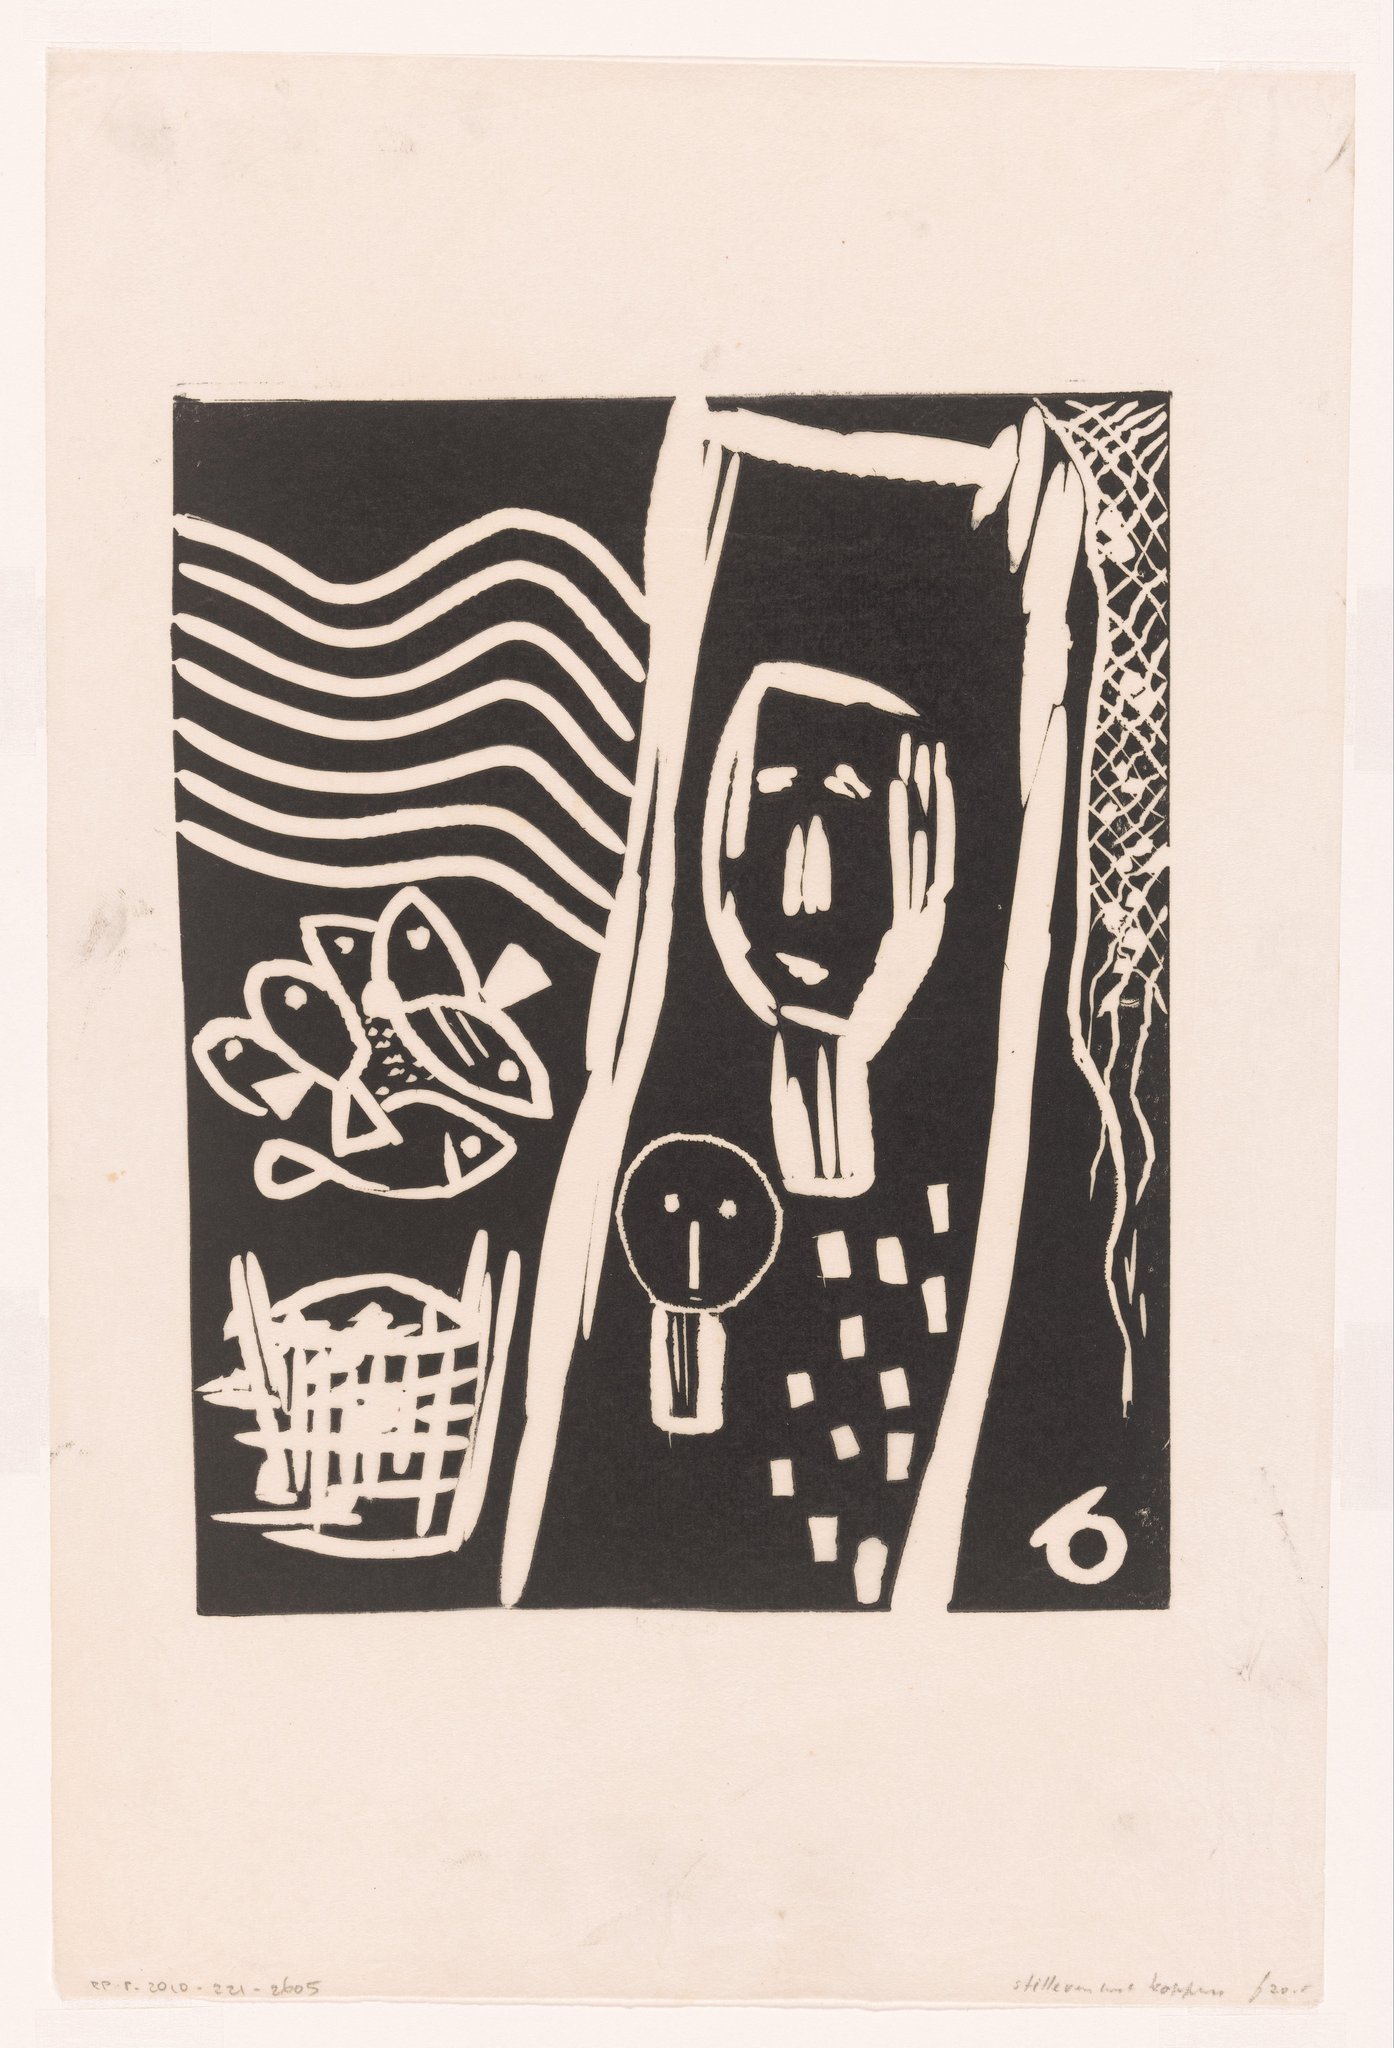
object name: print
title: Stilleven met koppen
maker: tames oud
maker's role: print maker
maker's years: 1895-1953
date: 1950-1953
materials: paper, ink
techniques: linocut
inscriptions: edition: ‘stilleven met koppen/ f.20-’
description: Compositie met twee gedeformeerde koppen, vissen en een mand.